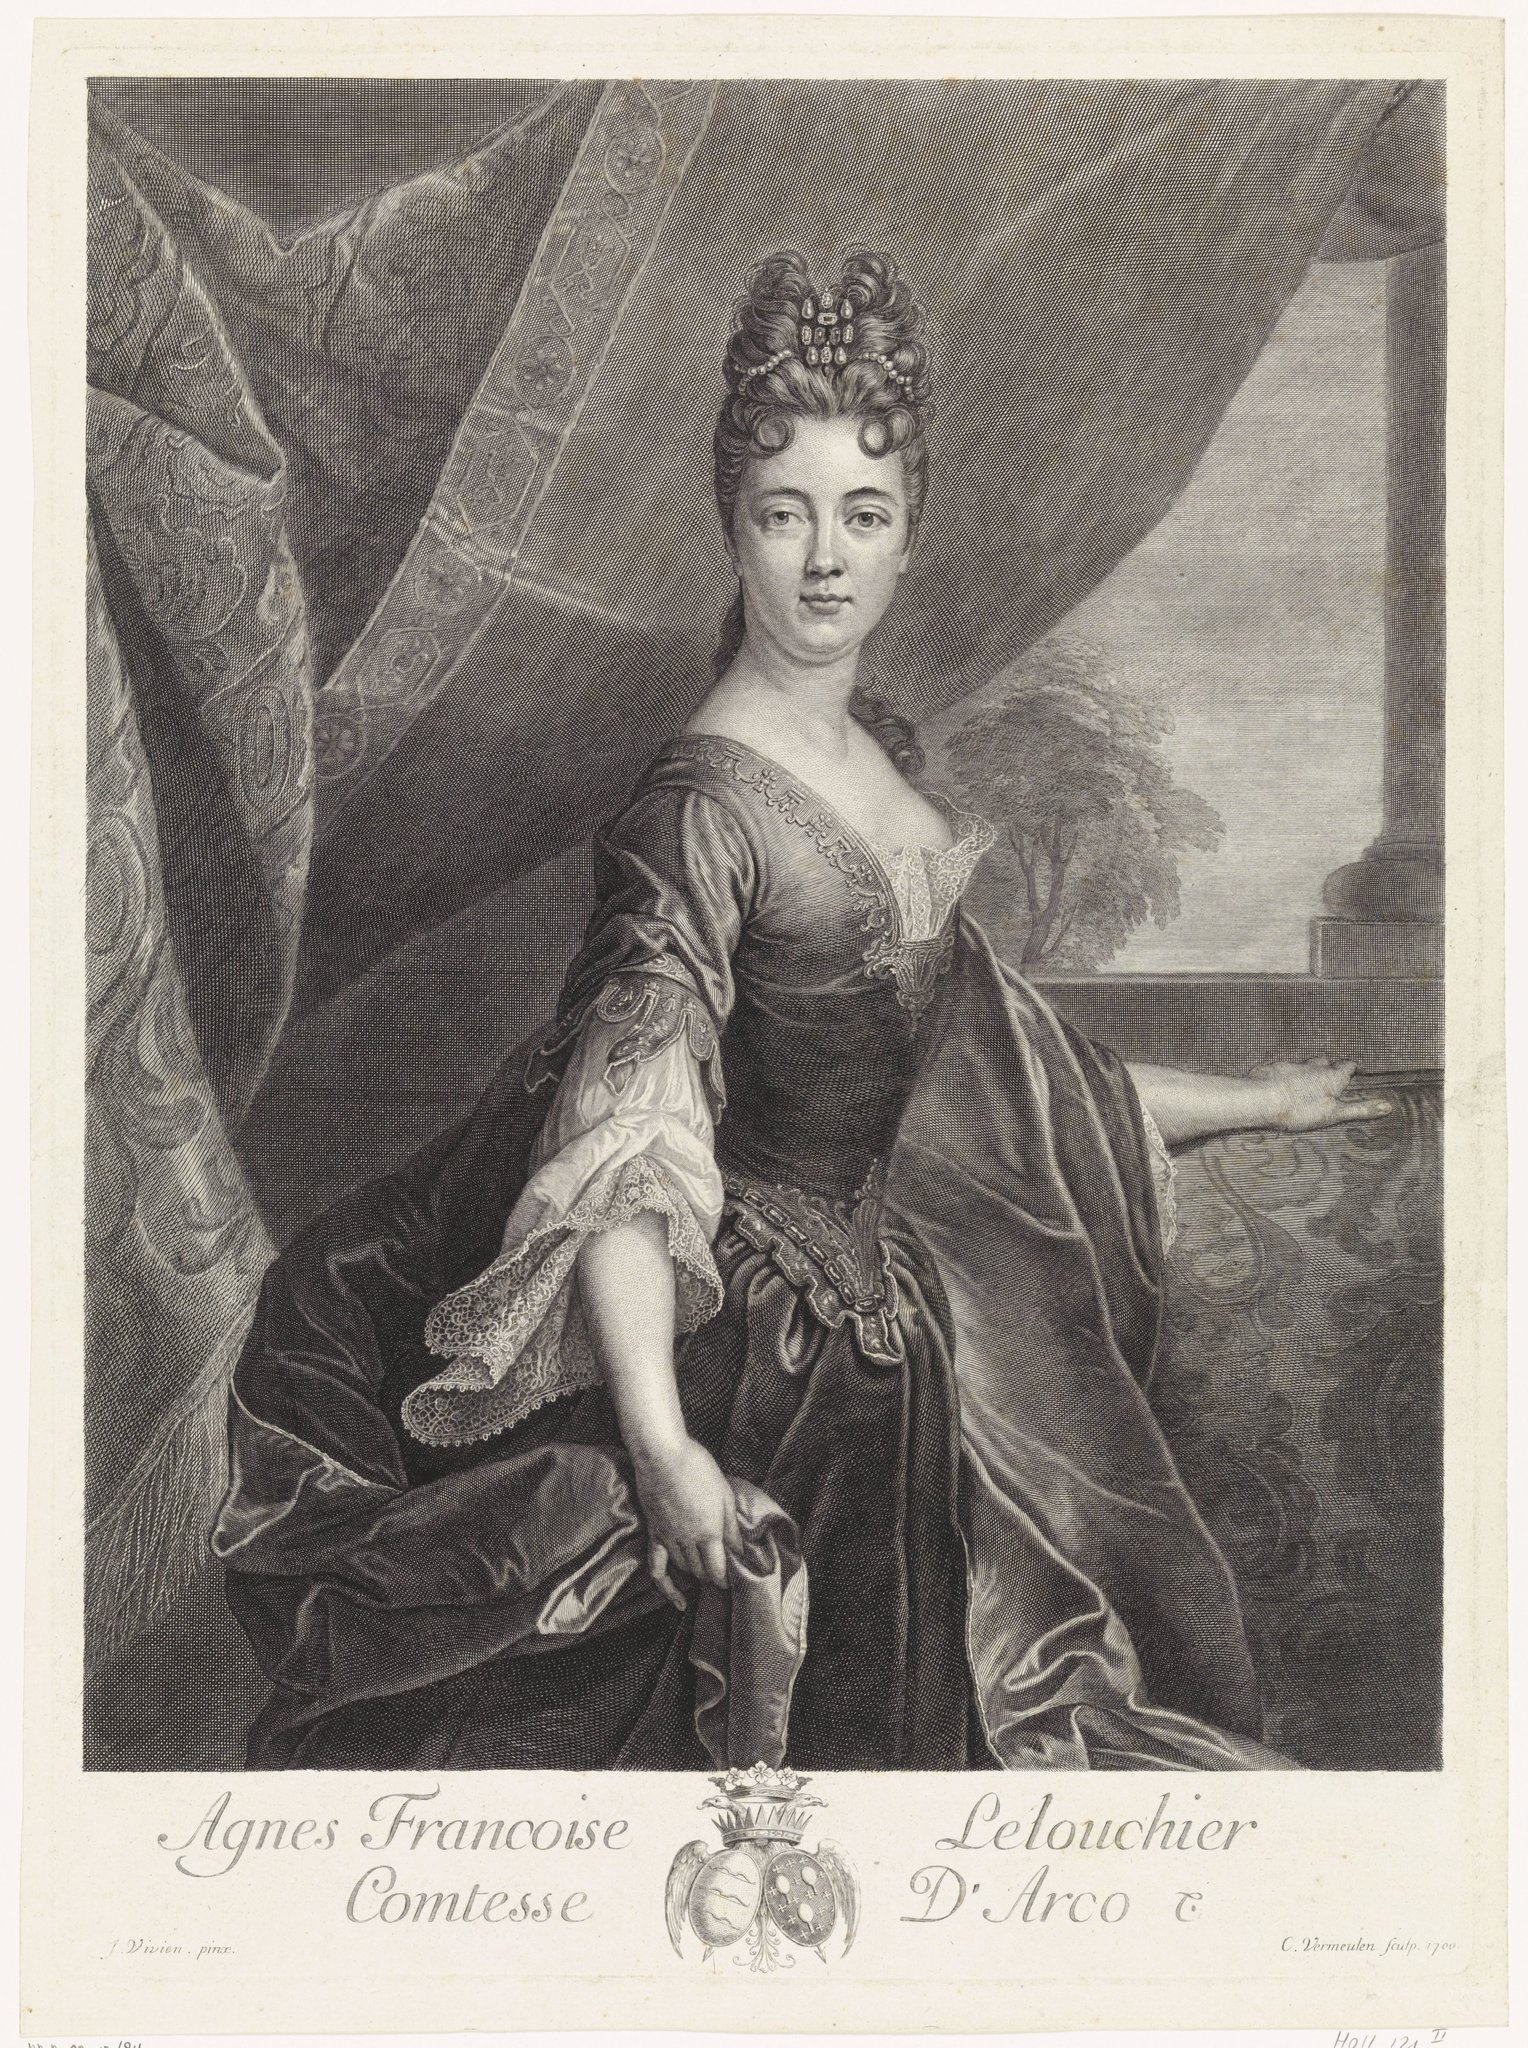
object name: print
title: Portret van Agnès Françoise Lelouchier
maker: joseph vivien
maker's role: painter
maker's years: 1657-1735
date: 1700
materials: paper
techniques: engraving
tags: danseres, agnes françoise le louchier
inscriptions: collector's mark: Lugt 240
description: De Franse danseres en gravin Agnès Françoise Lelouchier, staand onder een draperie.